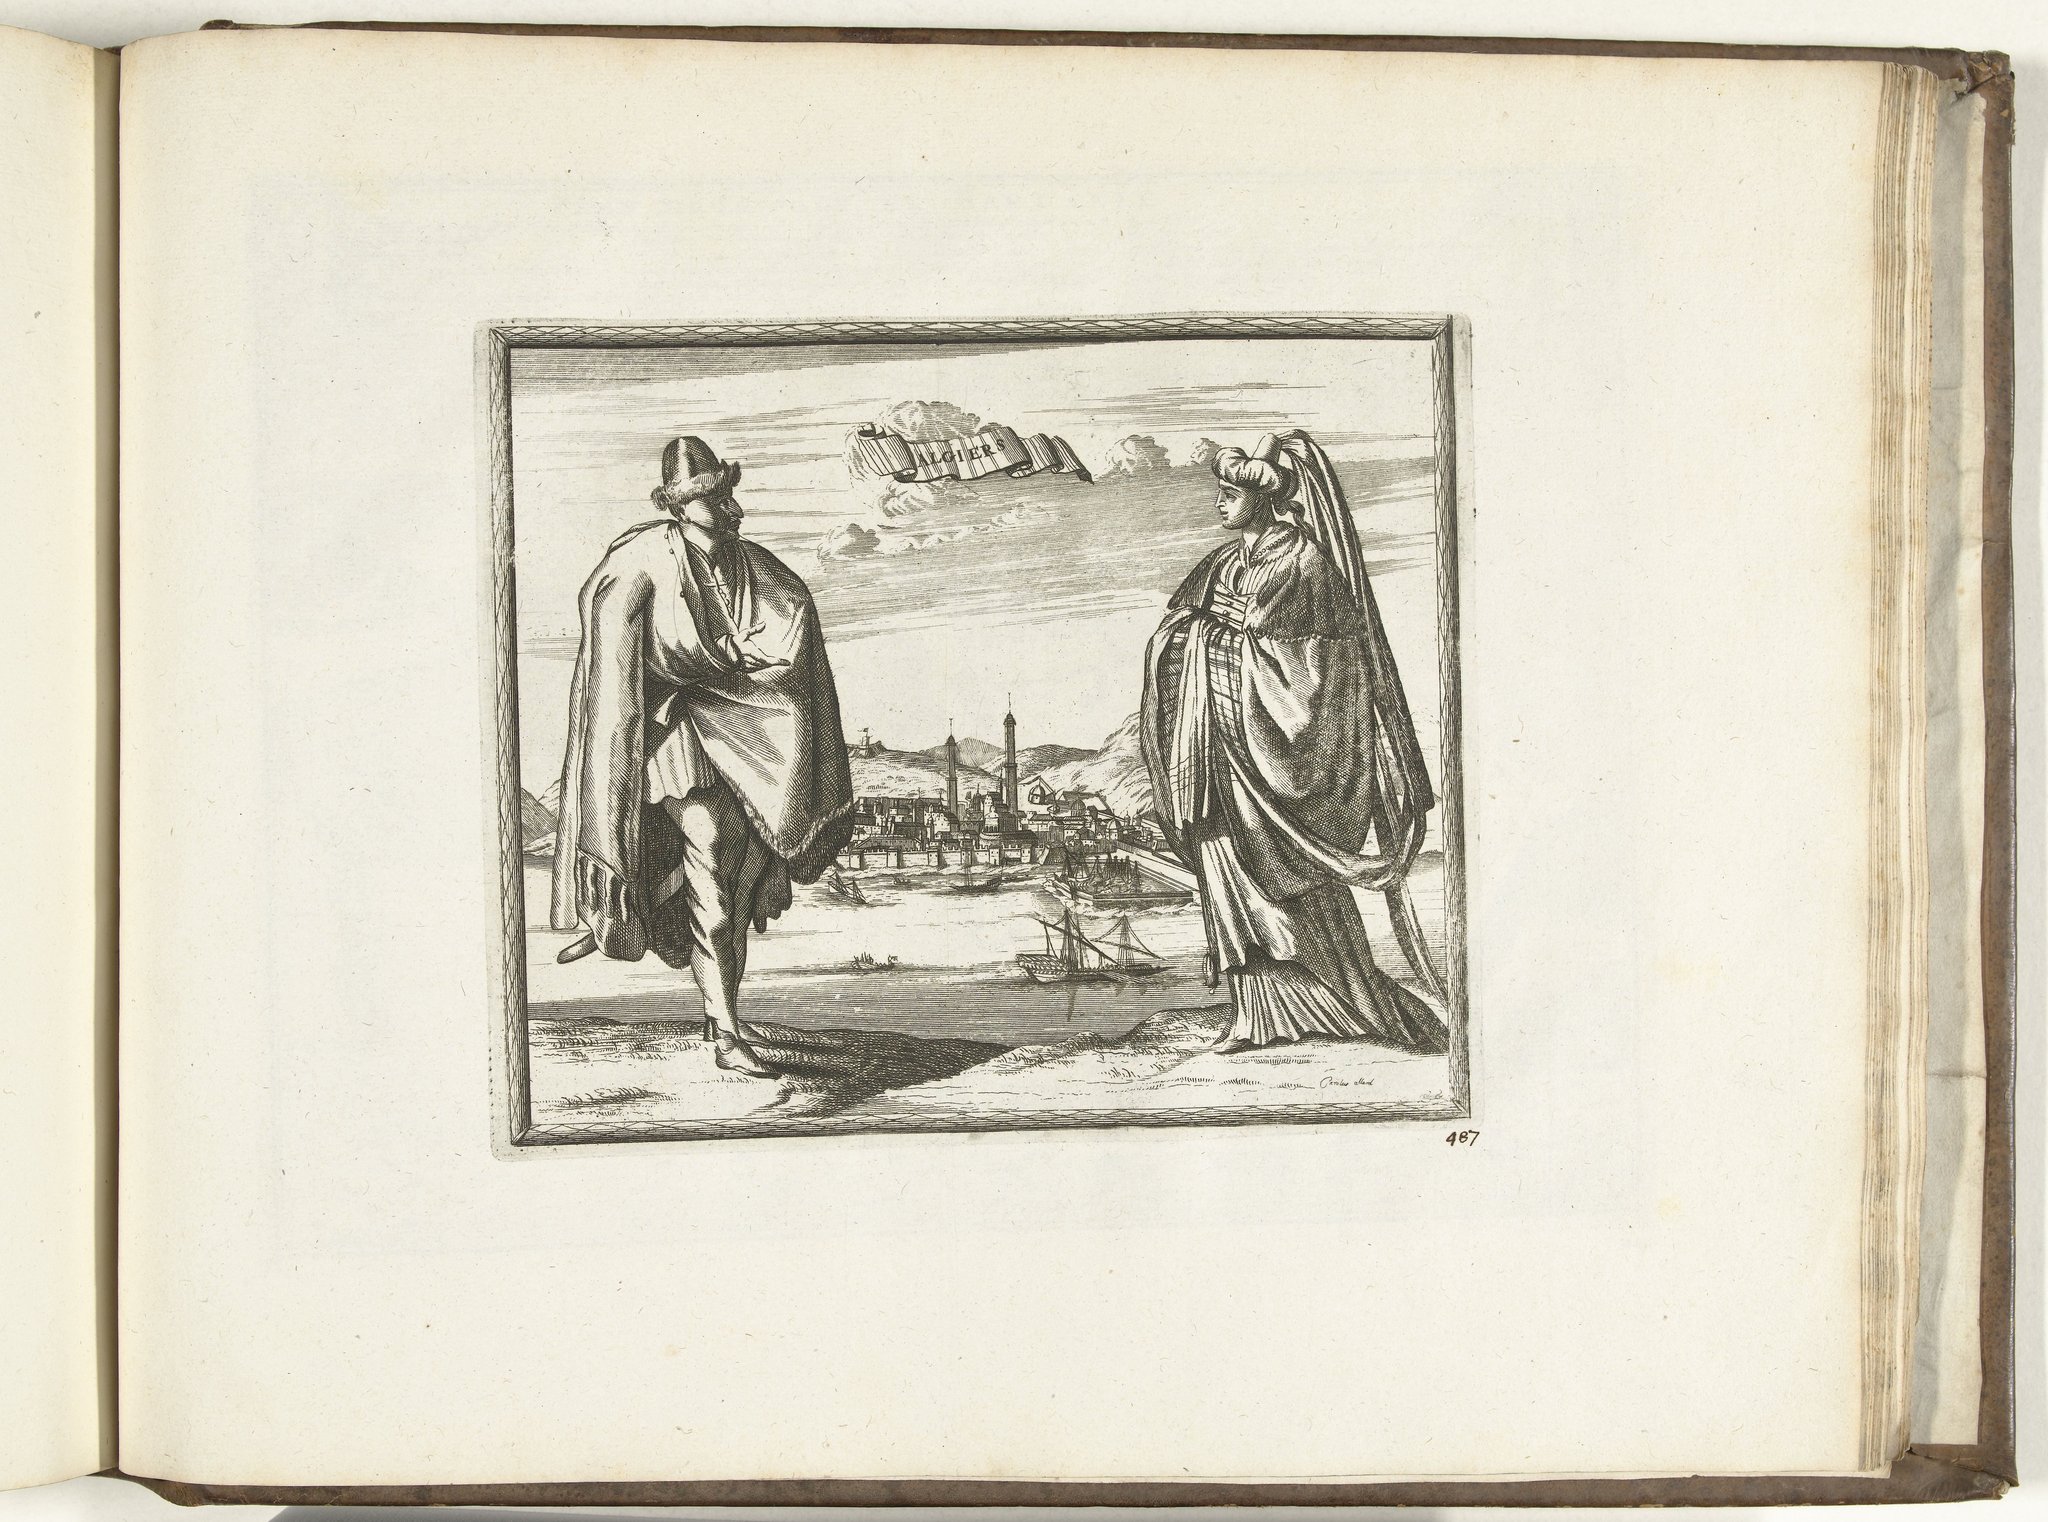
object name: print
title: Inwoners van Algiers, 1726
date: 1726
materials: paper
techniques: etching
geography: amsterdam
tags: africans, folk costume, regional costume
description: Man en vrouw van Algiers, gekleed in lokaal kostuum, op de achtergrond de stad. Plaat nr. 487 in deel XX van het prentwerk: Les Forces de l'Europe, Asie, Afrique et Amerique ... Comme aussi les Cartes des Côtes de France et d'Espagne uit 1726, dit tweede deel met 271 met de hand genummerde platen van vermaarde sterke steden en vestingen in het kader van de Spaanse Successieoorlog 1701-1713. Voor het merendeel zijn deze platen gekopieerd naar de anonieme Franse platen van vermaarde sterke steden en vestingen: in Les forces de l'Europe en in: Le theatre de la guerre, dans les Pays-Bas, beide oorspronkelijk uitgegeven door Nicolas de Fer te Parijs (1693-1697) in het kader van de Negenjarige Oorlog.